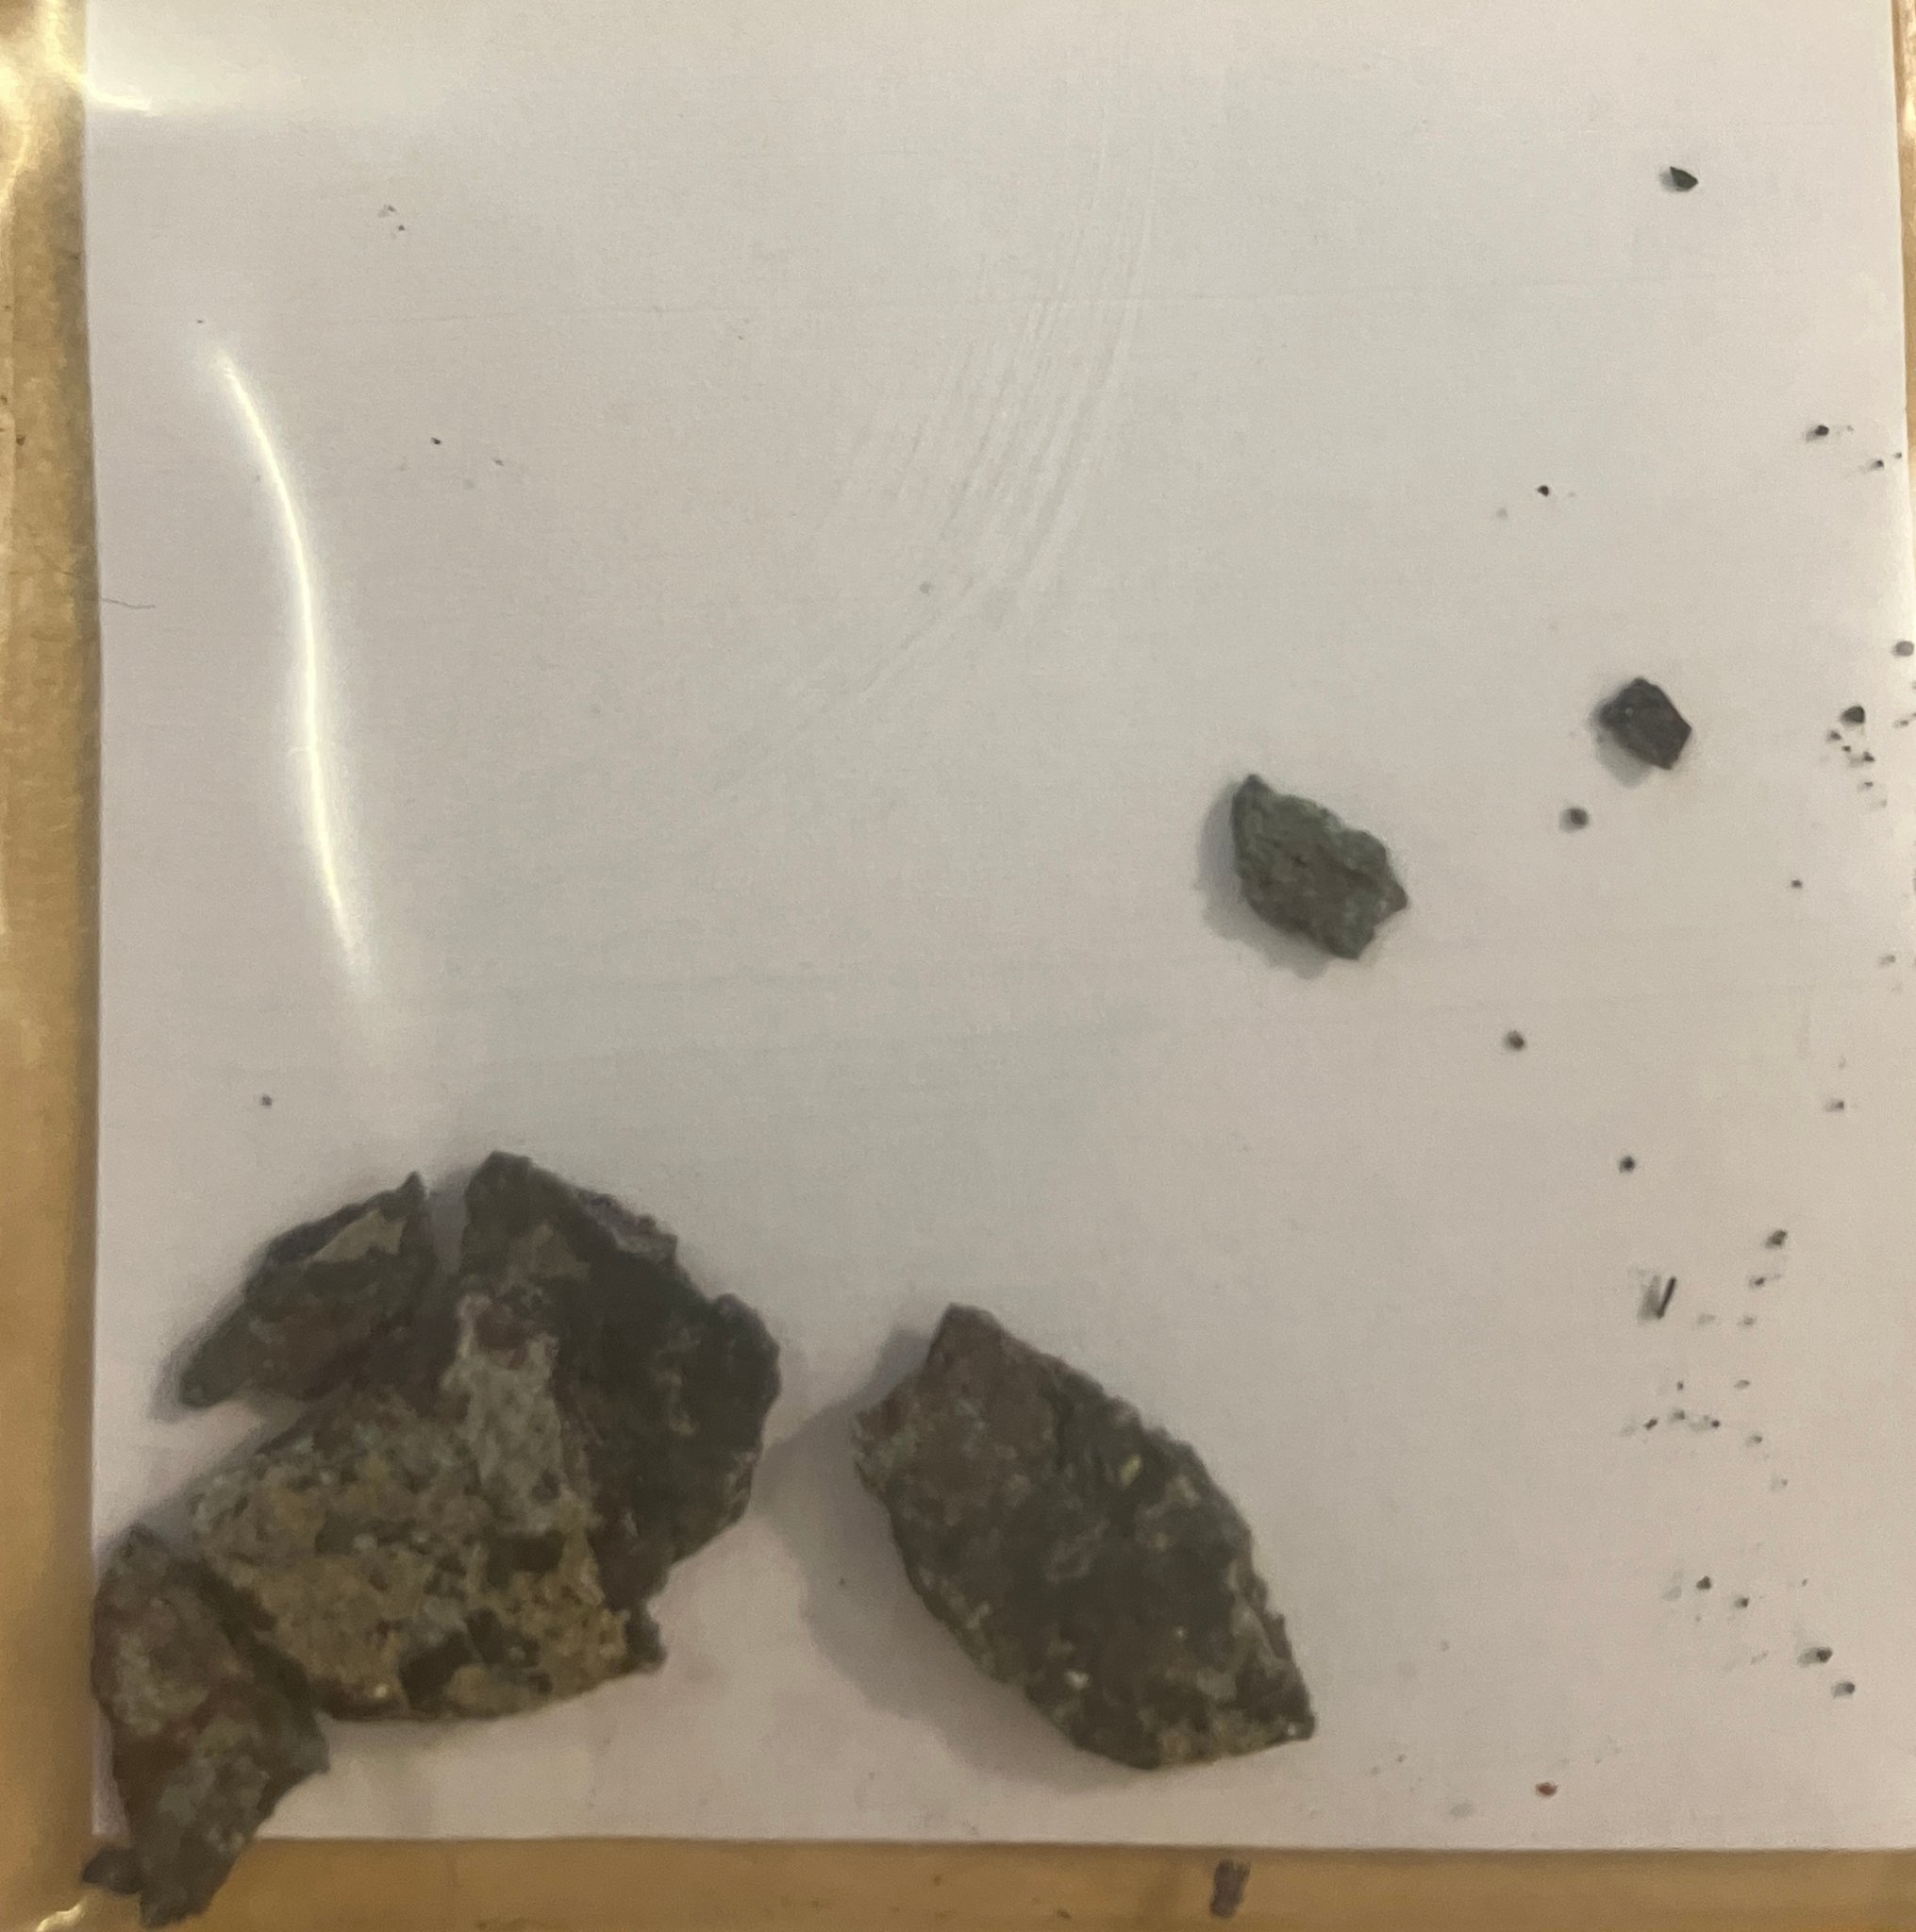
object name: coin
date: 401-1400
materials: silver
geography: iran